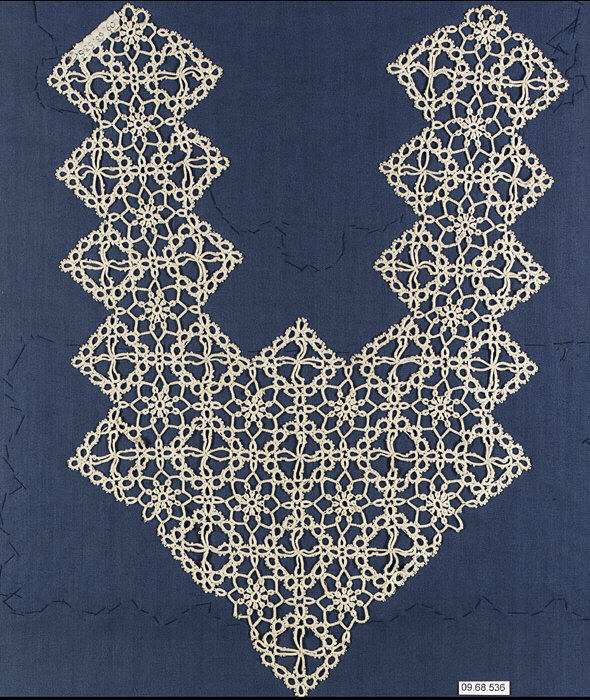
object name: cap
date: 1801-1900